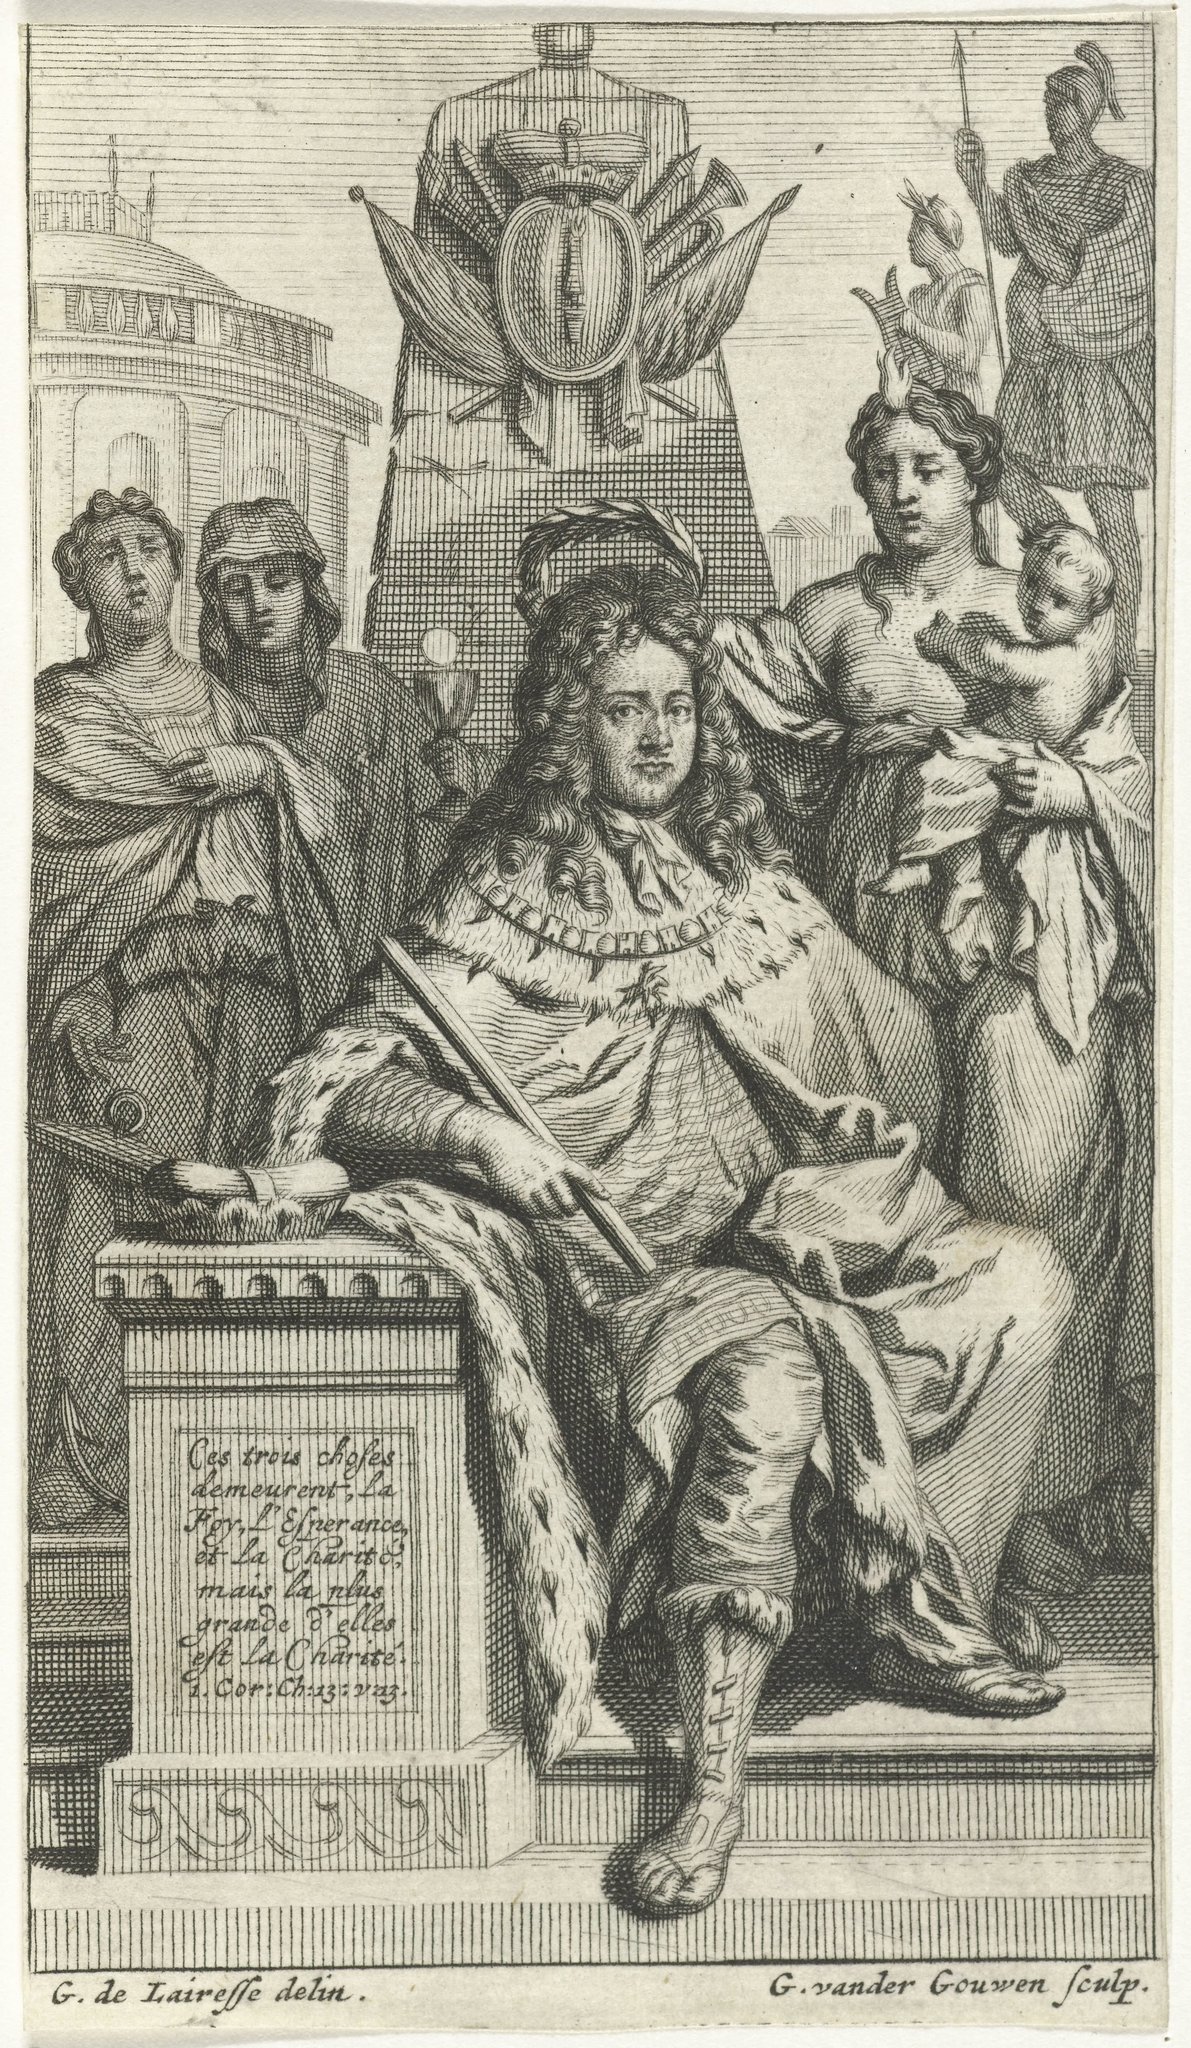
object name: titelblad, titelpagina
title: Portret van Frederik I van Pruisen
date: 1670-1740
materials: paper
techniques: engraving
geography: amsterdam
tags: frederik i koning van pruisen, obelisk, needle, the three theological virtues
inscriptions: collector's mark: Lugt 240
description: Frederik I van Pruisen zit leunend tegen een voetstuk met een Franse tekst. Hij wordt met een lauwerkrans gekroond door Liefde (Caritas), met een kind aan haar schouder en een vlam op haar hoofd. Op de achtergrond een monumentale obelisk en de personificaties Geloof (Fides) en Hoop (Spes).